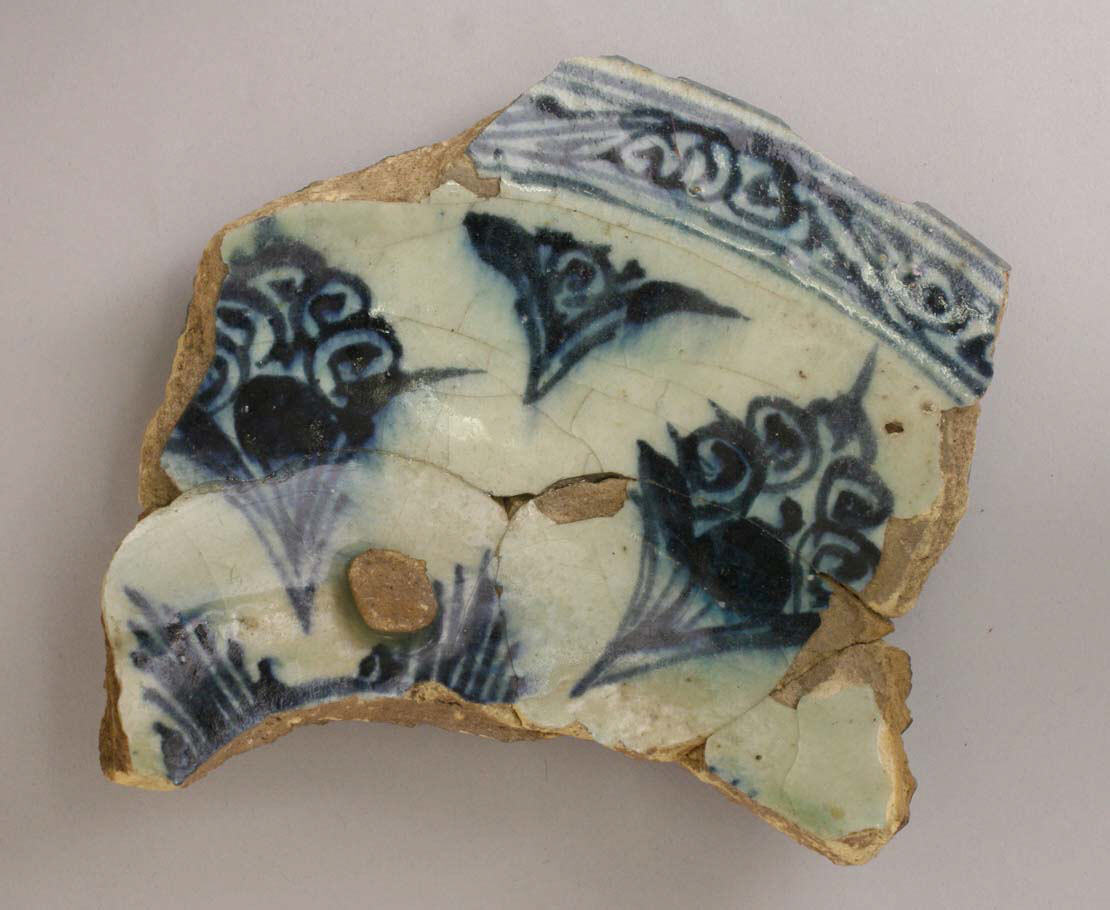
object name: ceramic fragment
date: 1301-1400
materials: glaze, stonepaste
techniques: painting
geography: syria